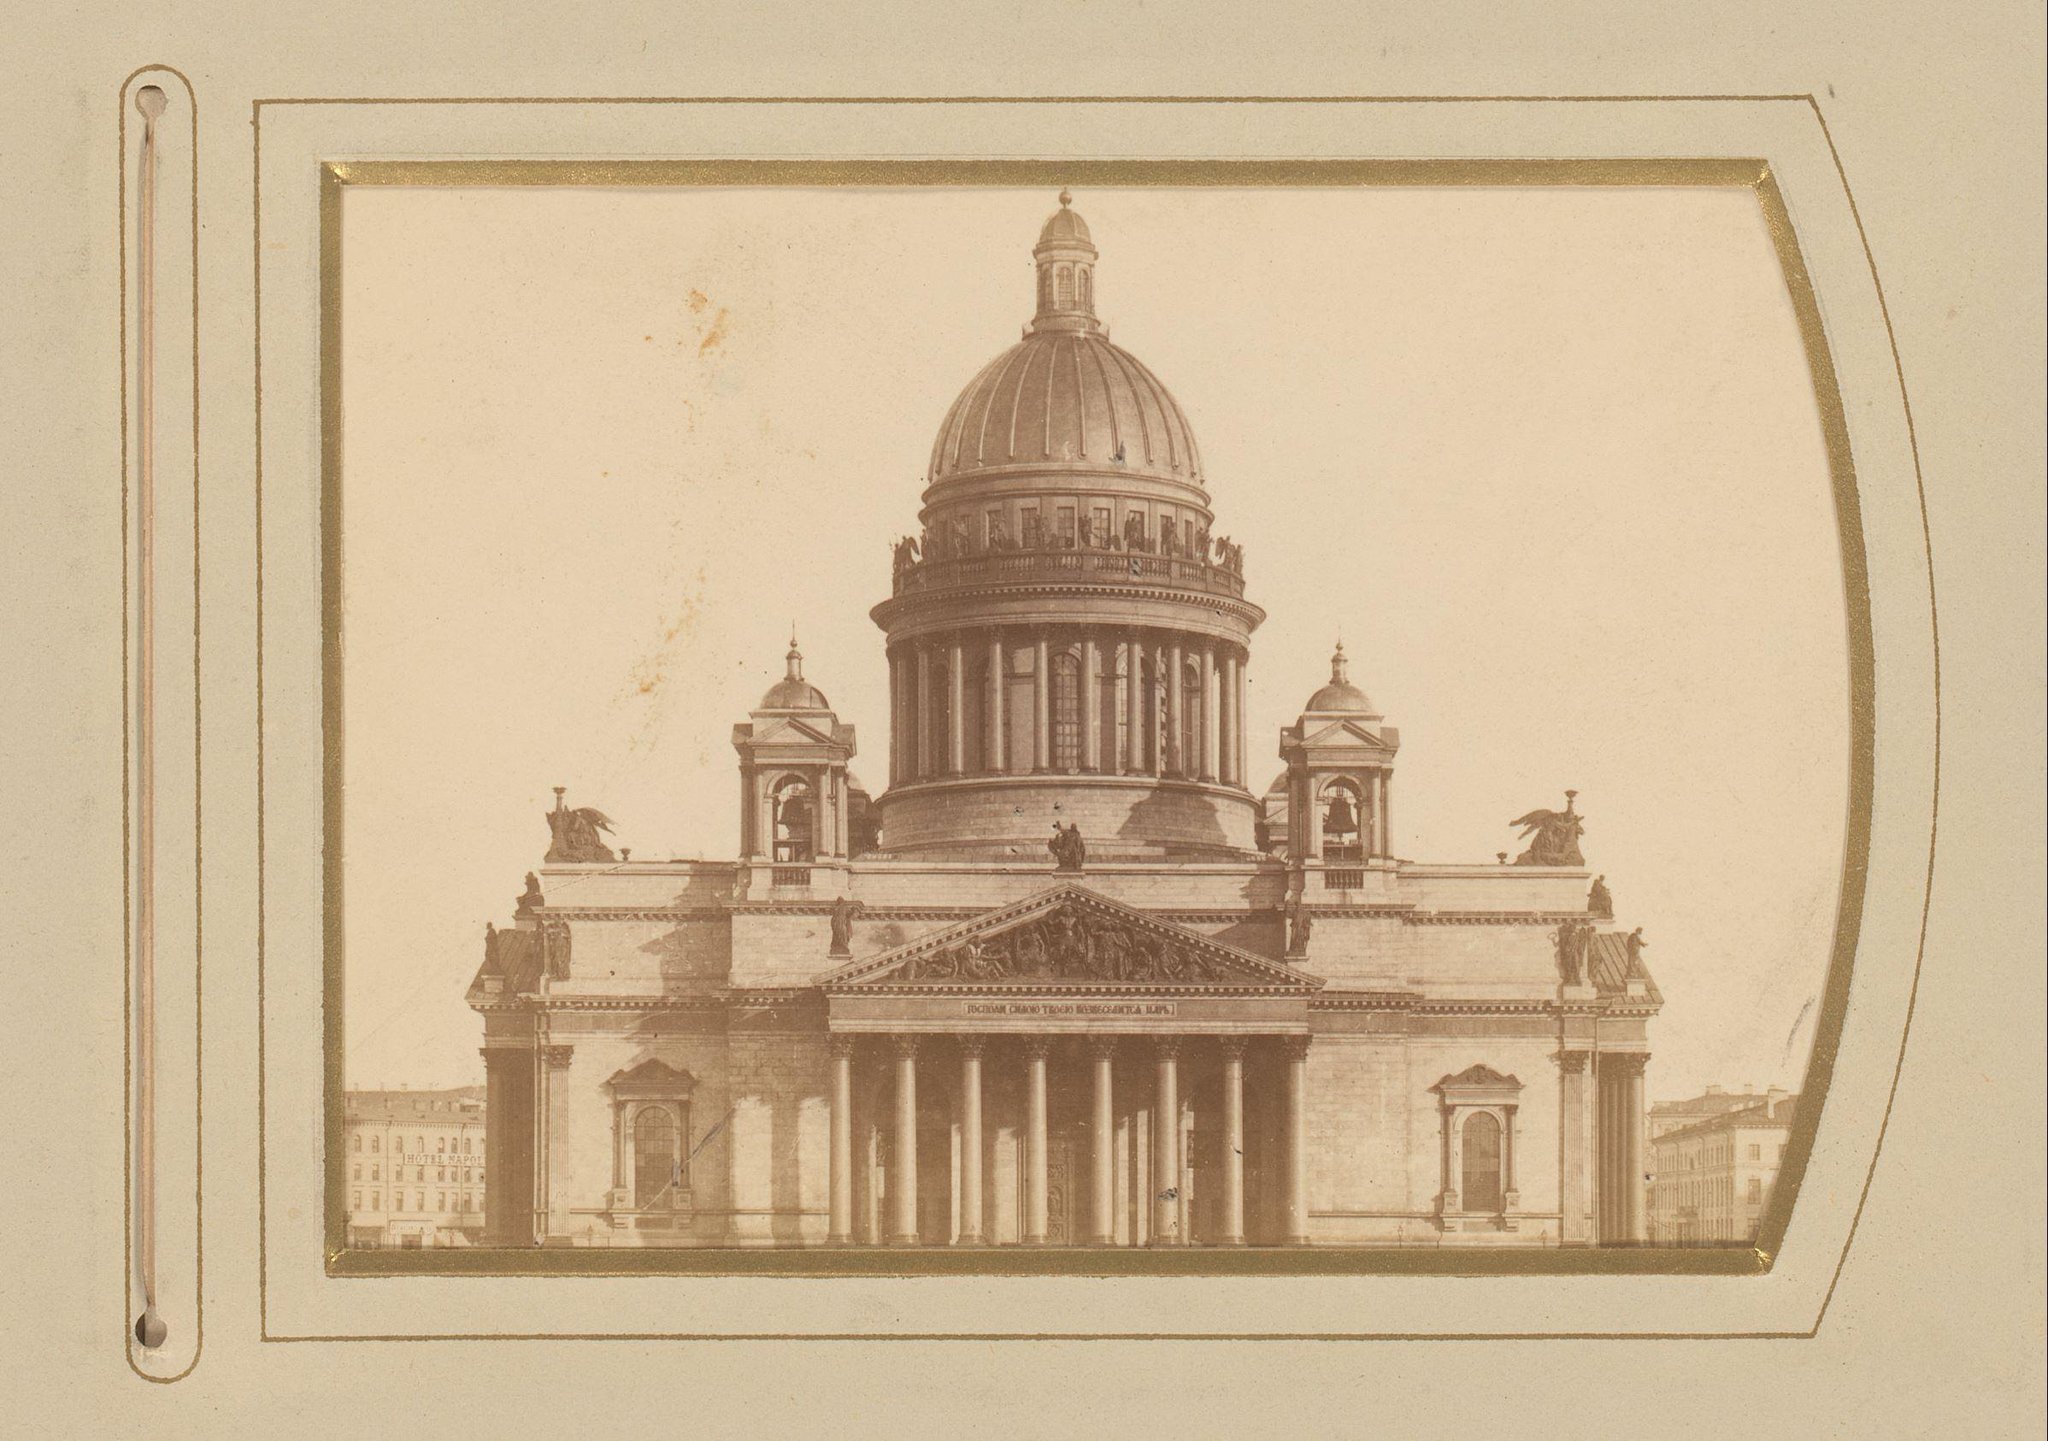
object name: cabinet photograph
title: St. Petersbourg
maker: Anonymous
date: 1850-1900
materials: cardboard, photographic support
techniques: albumen print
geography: sint-petersburg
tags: church (exterior)